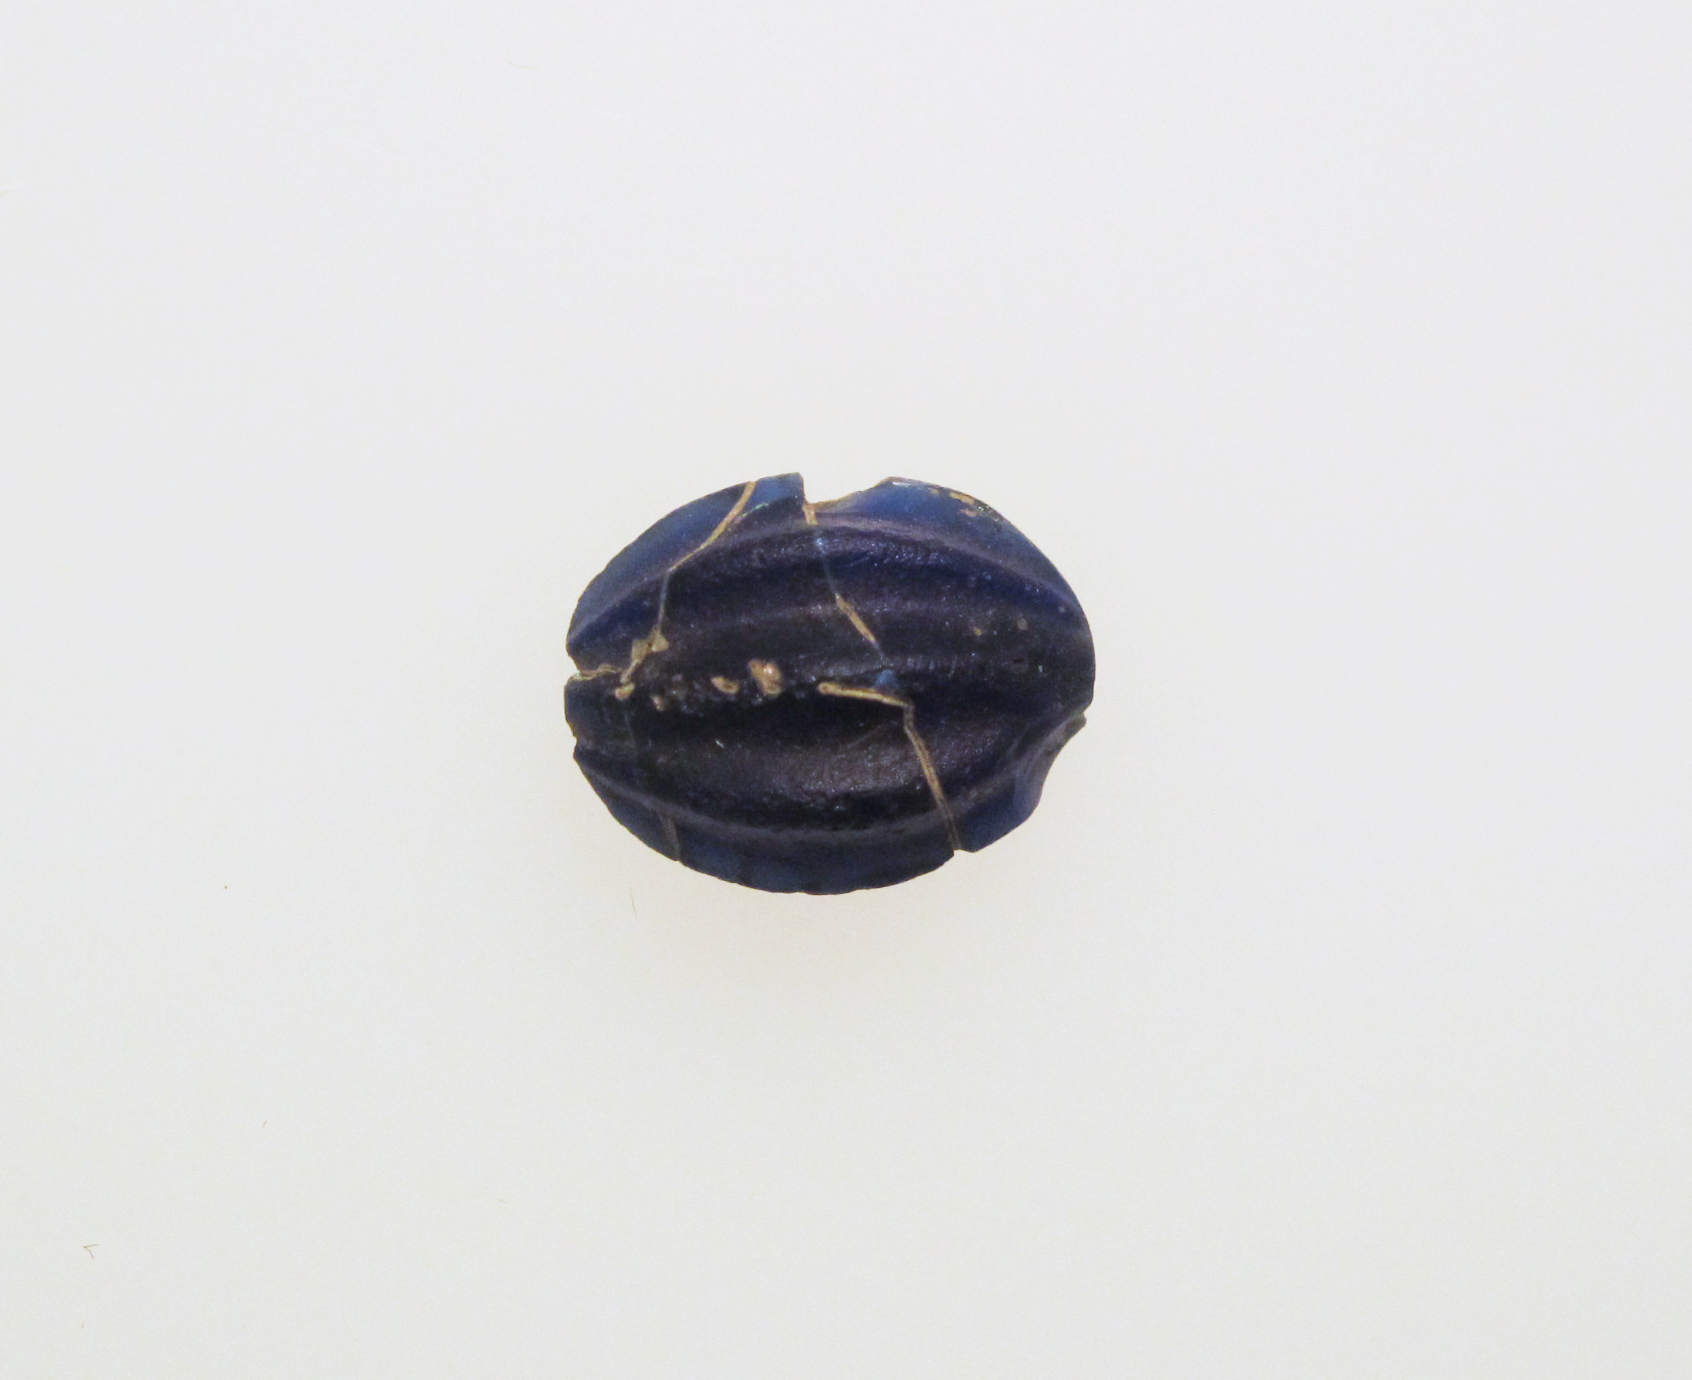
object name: bead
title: Glass spacer bead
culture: roman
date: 1-33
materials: glass